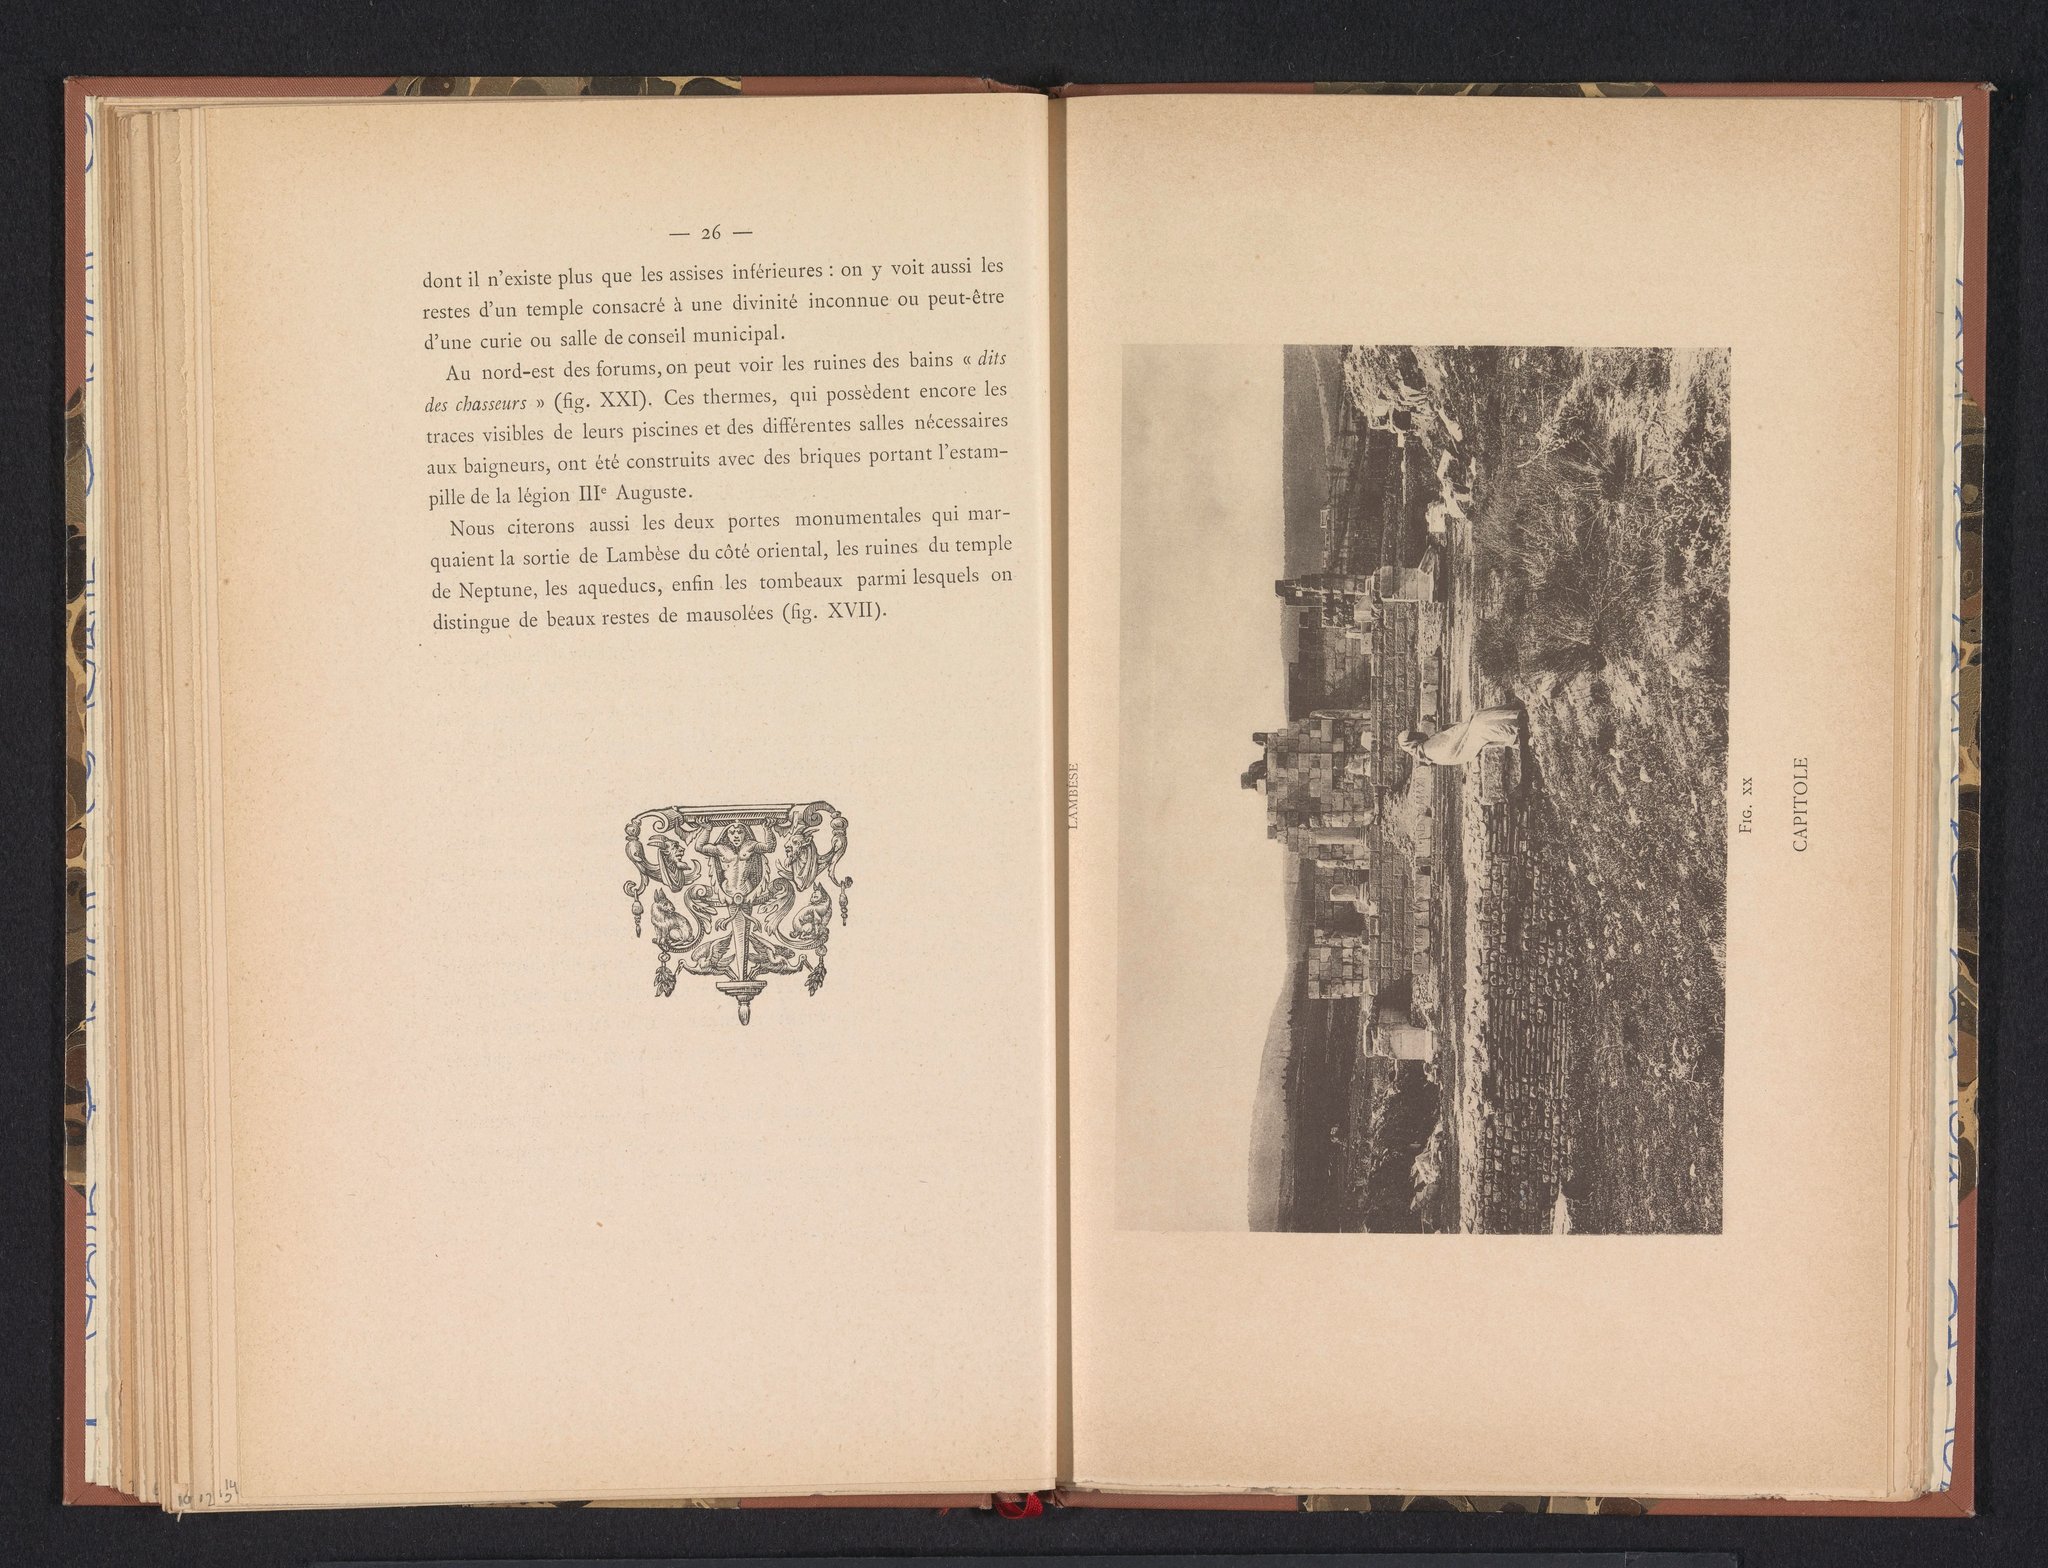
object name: page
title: Capitole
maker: Anonymous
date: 1884-1894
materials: paper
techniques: photograph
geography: france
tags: ruin of a building ~ architecture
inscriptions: number: ‘Fig. XX’